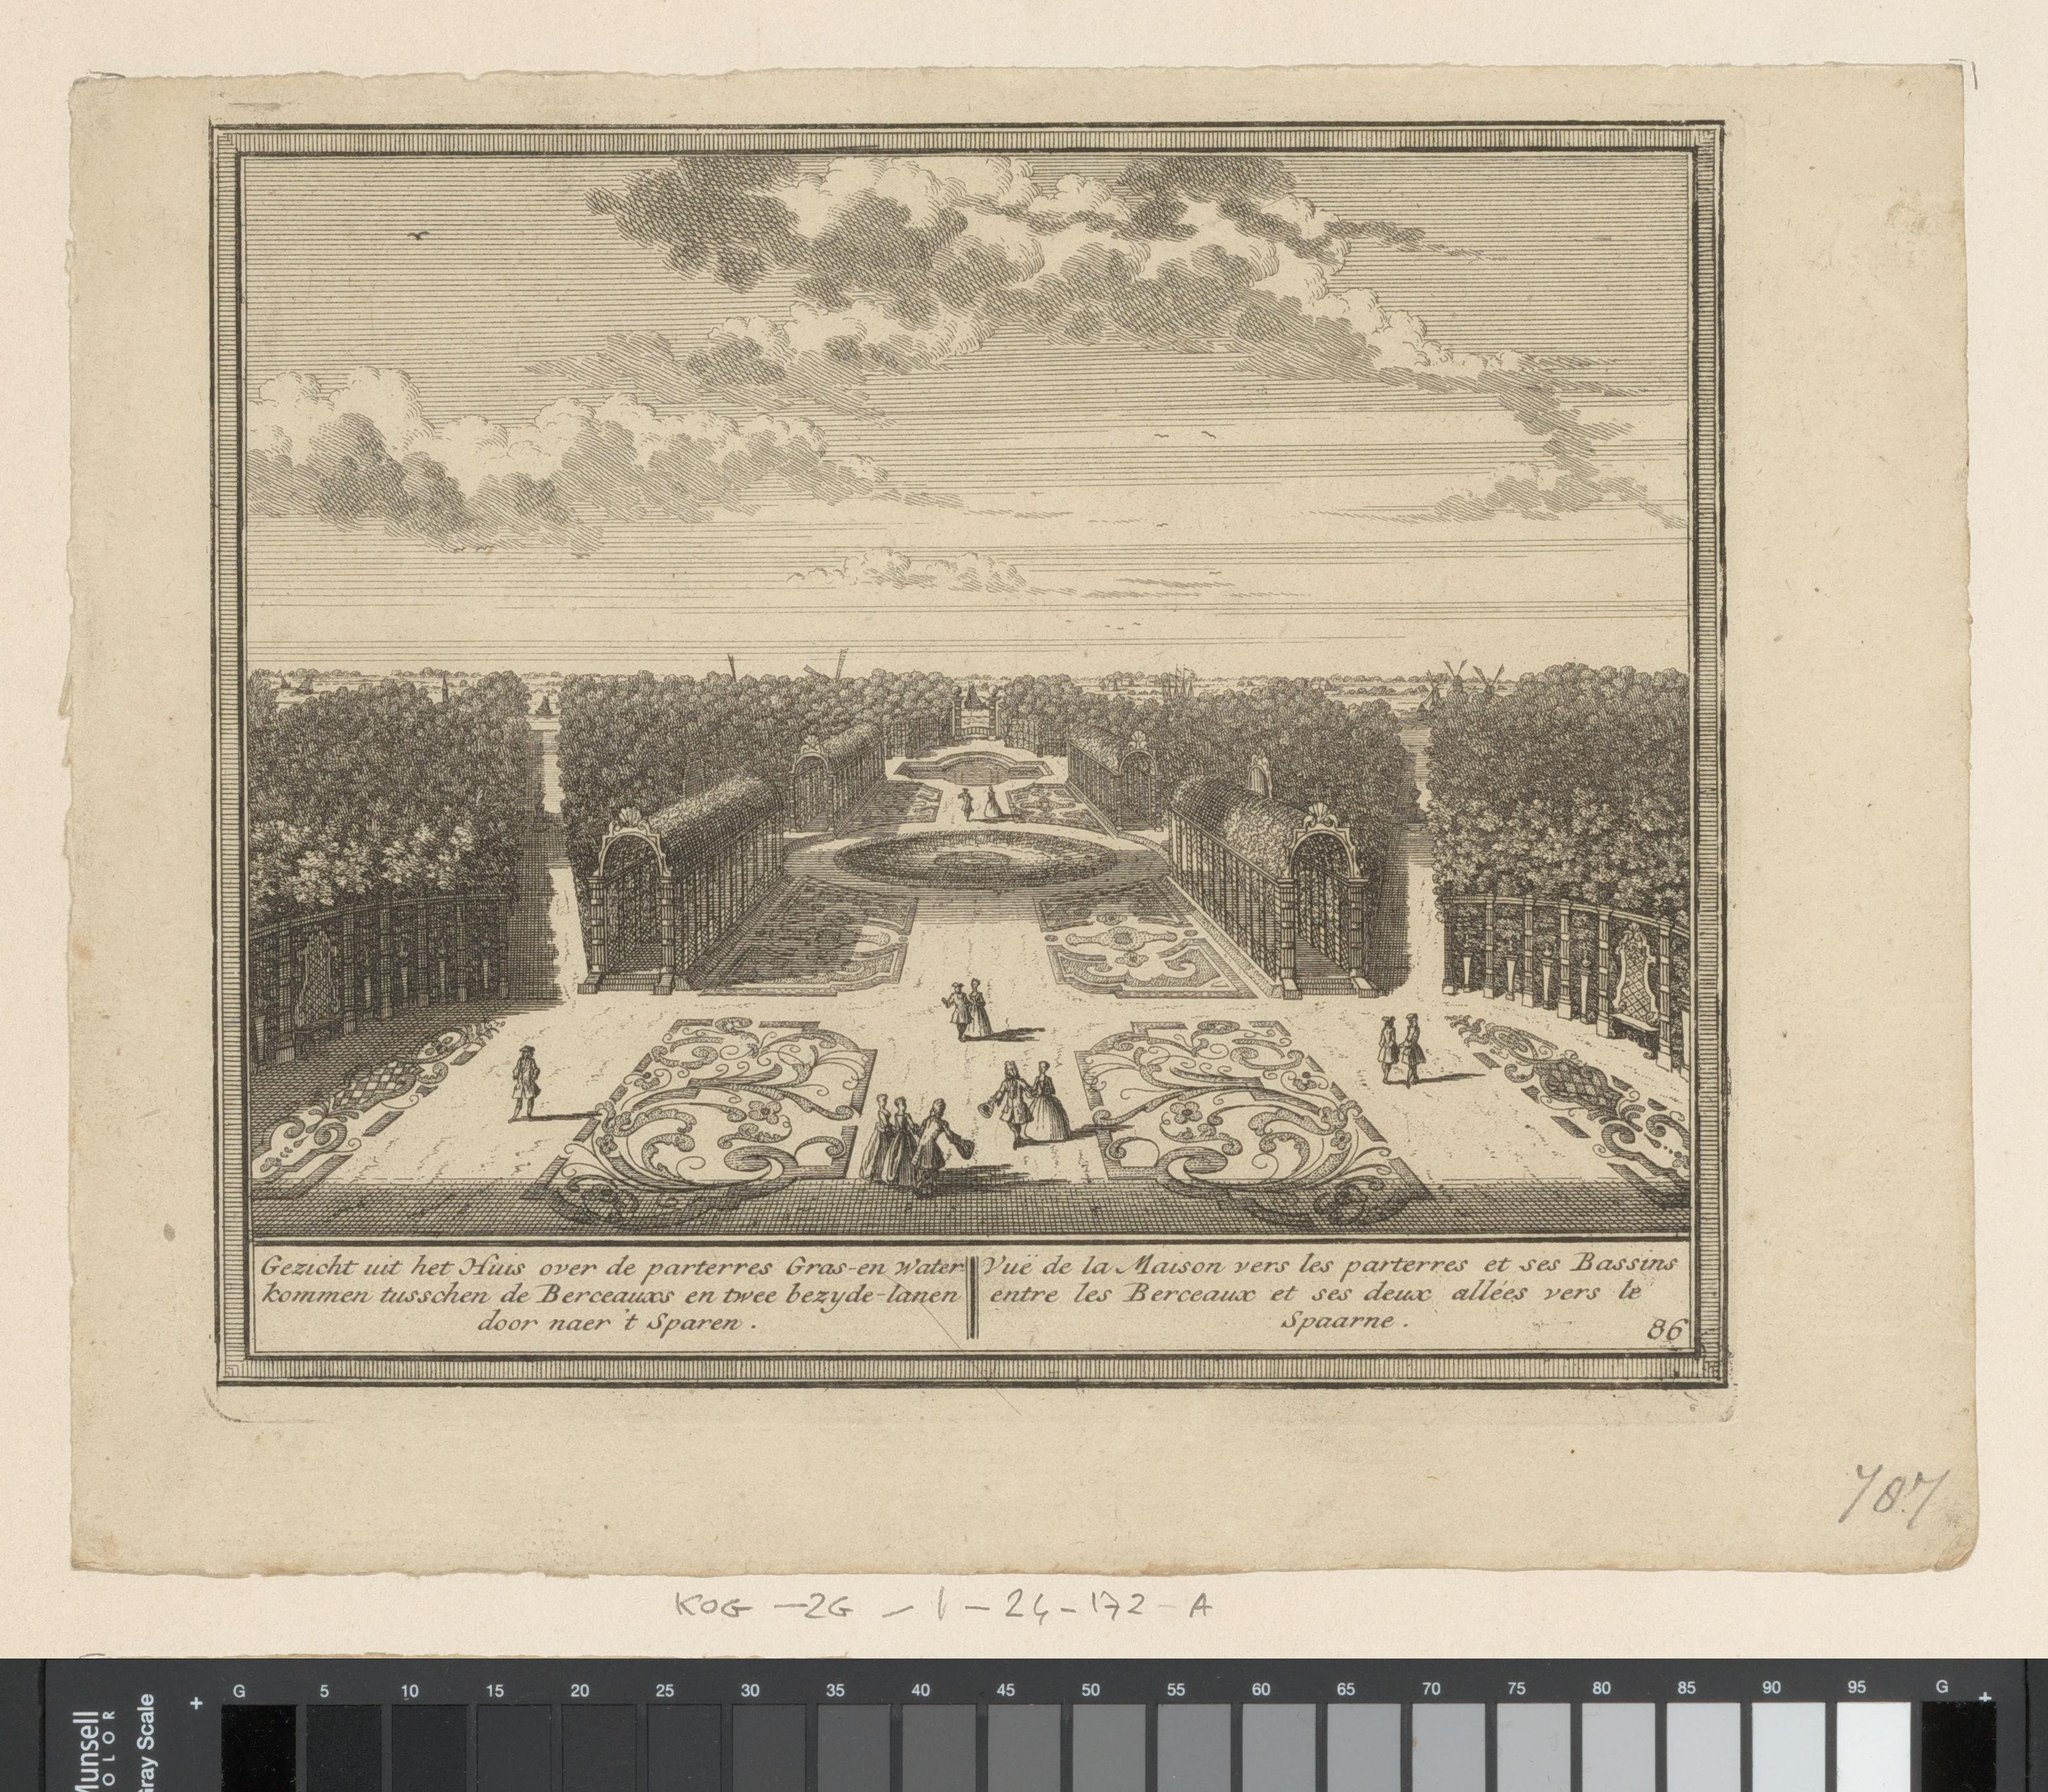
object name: print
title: Gezicht uit het Huis over de parterres Gras-en Waterkommen (...) / Vuë de la Maison vers les parterres et ses Bassins (...)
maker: hendrik de leth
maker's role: draughtsman, print maker, publisher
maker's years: 1703-1766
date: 1729-1732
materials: paper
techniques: engraving, etching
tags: french or architectonic garden; formal garden, country-house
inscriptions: stamp, collector's mark: Lugt 1641, stamp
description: Prent mogelijk uit: Brouërius van Nidek, Matthaeus. Het zegepralend Kennemerland, vertoond in 100 heerlyke gezichten. Amsterdam: Jan Roman, s.a. Of uit: Brouërius van Nidek, Matthaeus. Het zegepralend Kennemerland, vertoond in veele heerlyke gezichten. Amsterdam: Andries en Hendrik de Leth, s.a [1729-1732].